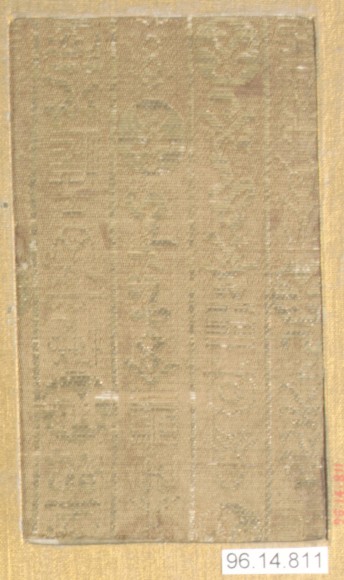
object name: piece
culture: japanese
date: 1701-1900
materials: metal thread, silk